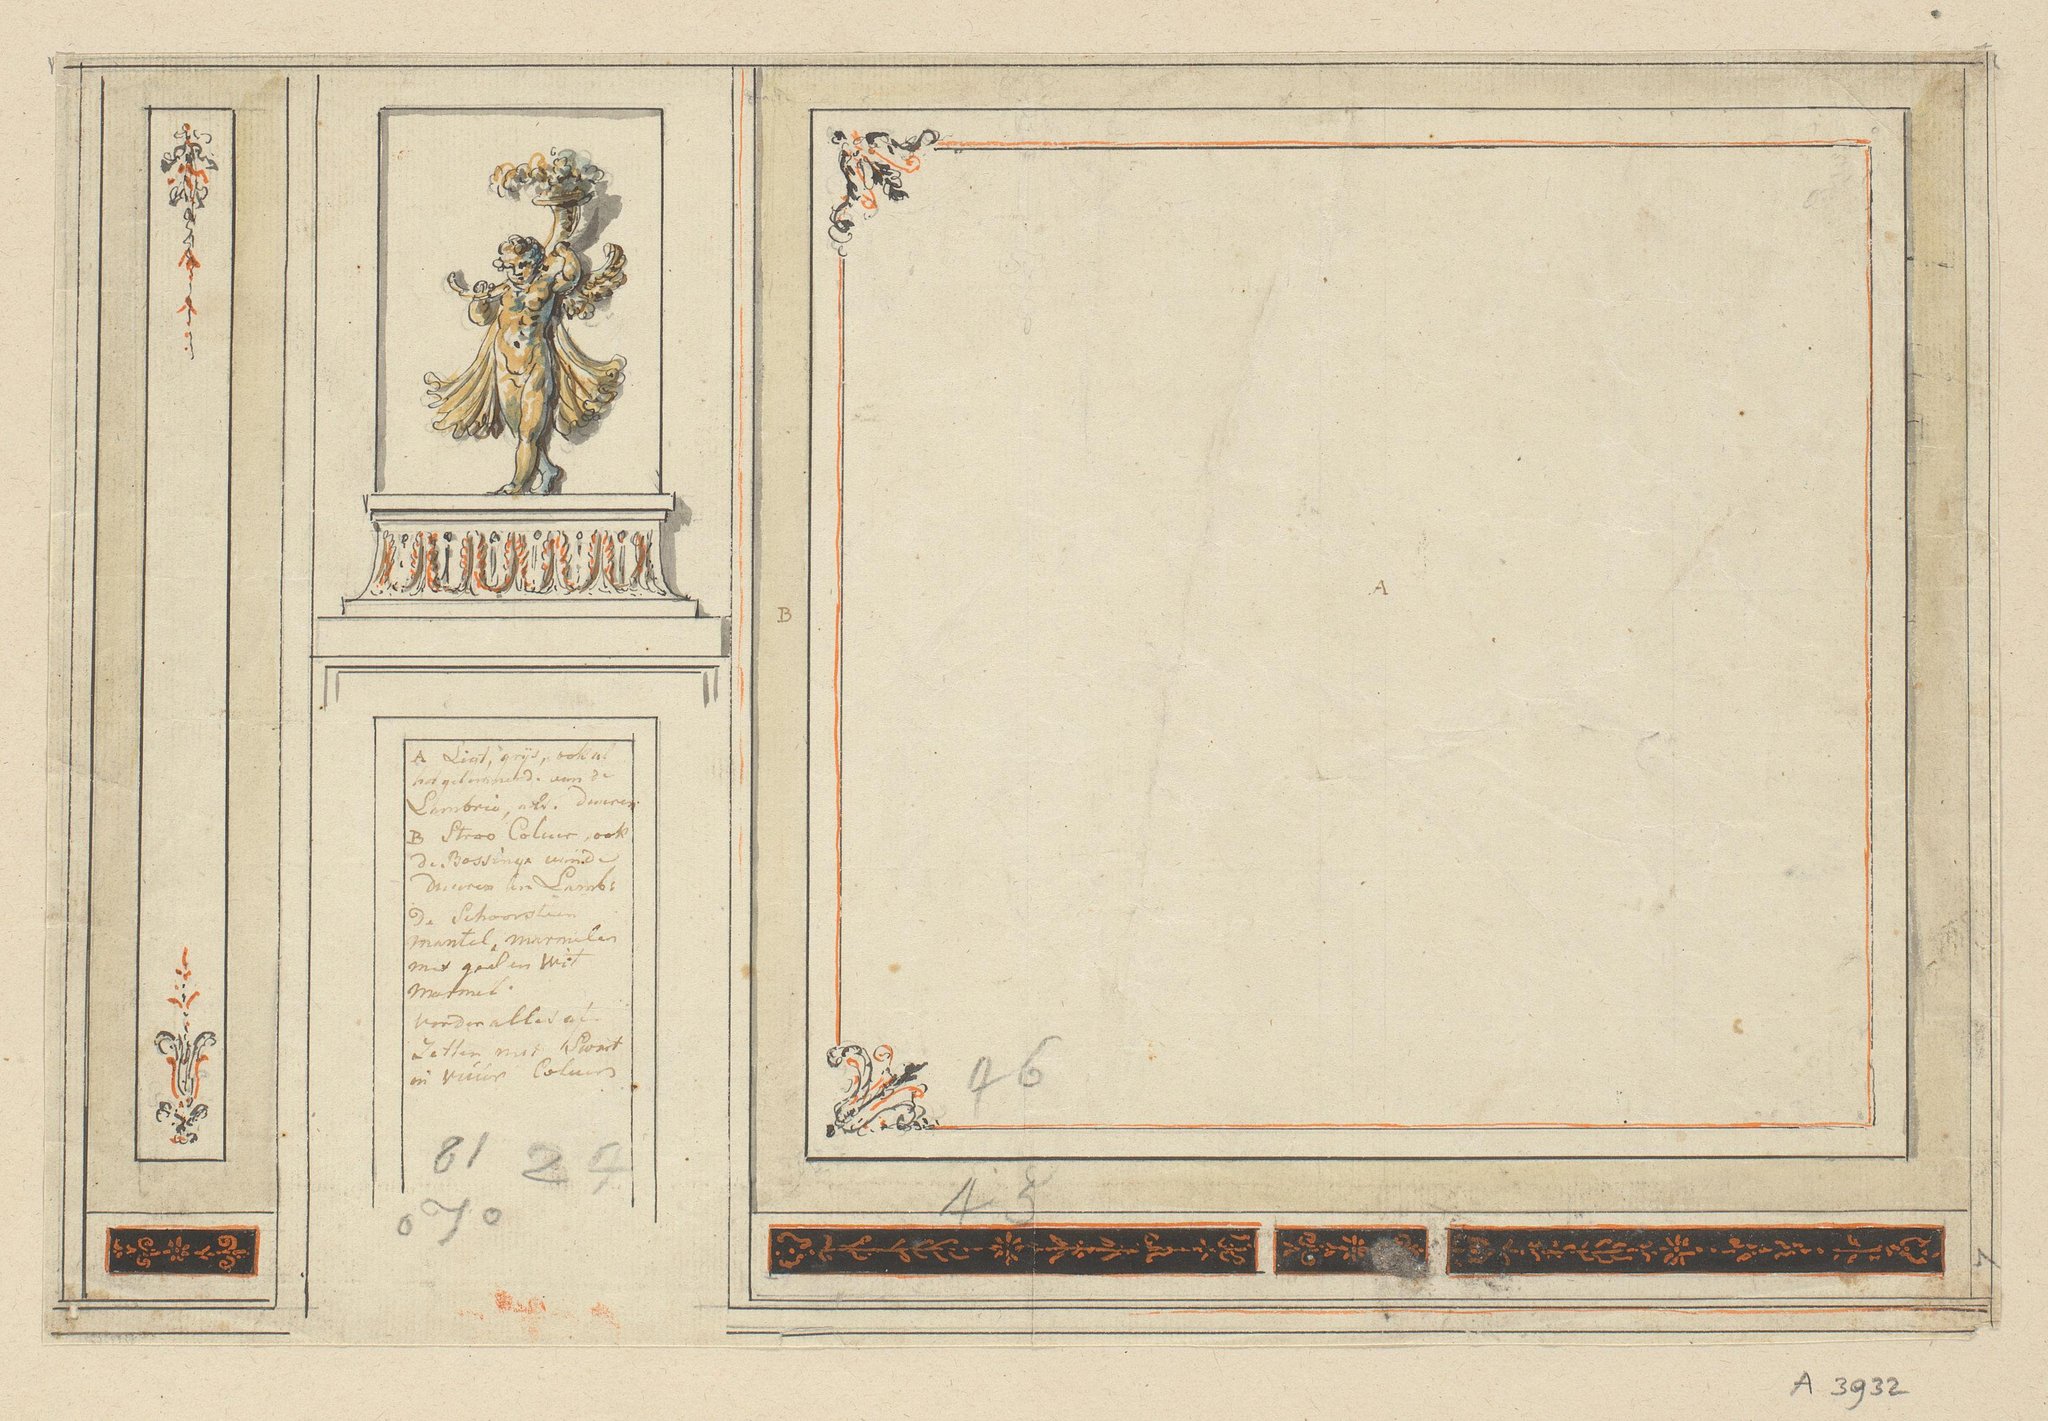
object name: drawing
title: Ontwerptekening voor een kamerwand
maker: abraham van strij (i)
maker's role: draughtsman, painter, print maker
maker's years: 1753-1826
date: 1763-1826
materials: paint, paper, pencil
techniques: brush, pen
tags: 'cornucopia', horn of plenty, wall-covering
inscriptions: collector's mark: Lugt 2228, inscription: ‘A Ligt, grijs, ook al/ het ge[...] van de/ lambrie, [...] deuren[?]/ B Stroo coluer, ook/ de Bossing[...]/ de schoorsteen/ mantel marmelen/ met geel en wit/ marmel./ voor den alles af./ zetten met swart/ en vuur coleur’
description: Met links een soort schouw met daarboven een putto met een hoorn des overvloeds. Met aantekeningen met kleuraanwijzingen. Tekening maakt deel uit van een album.